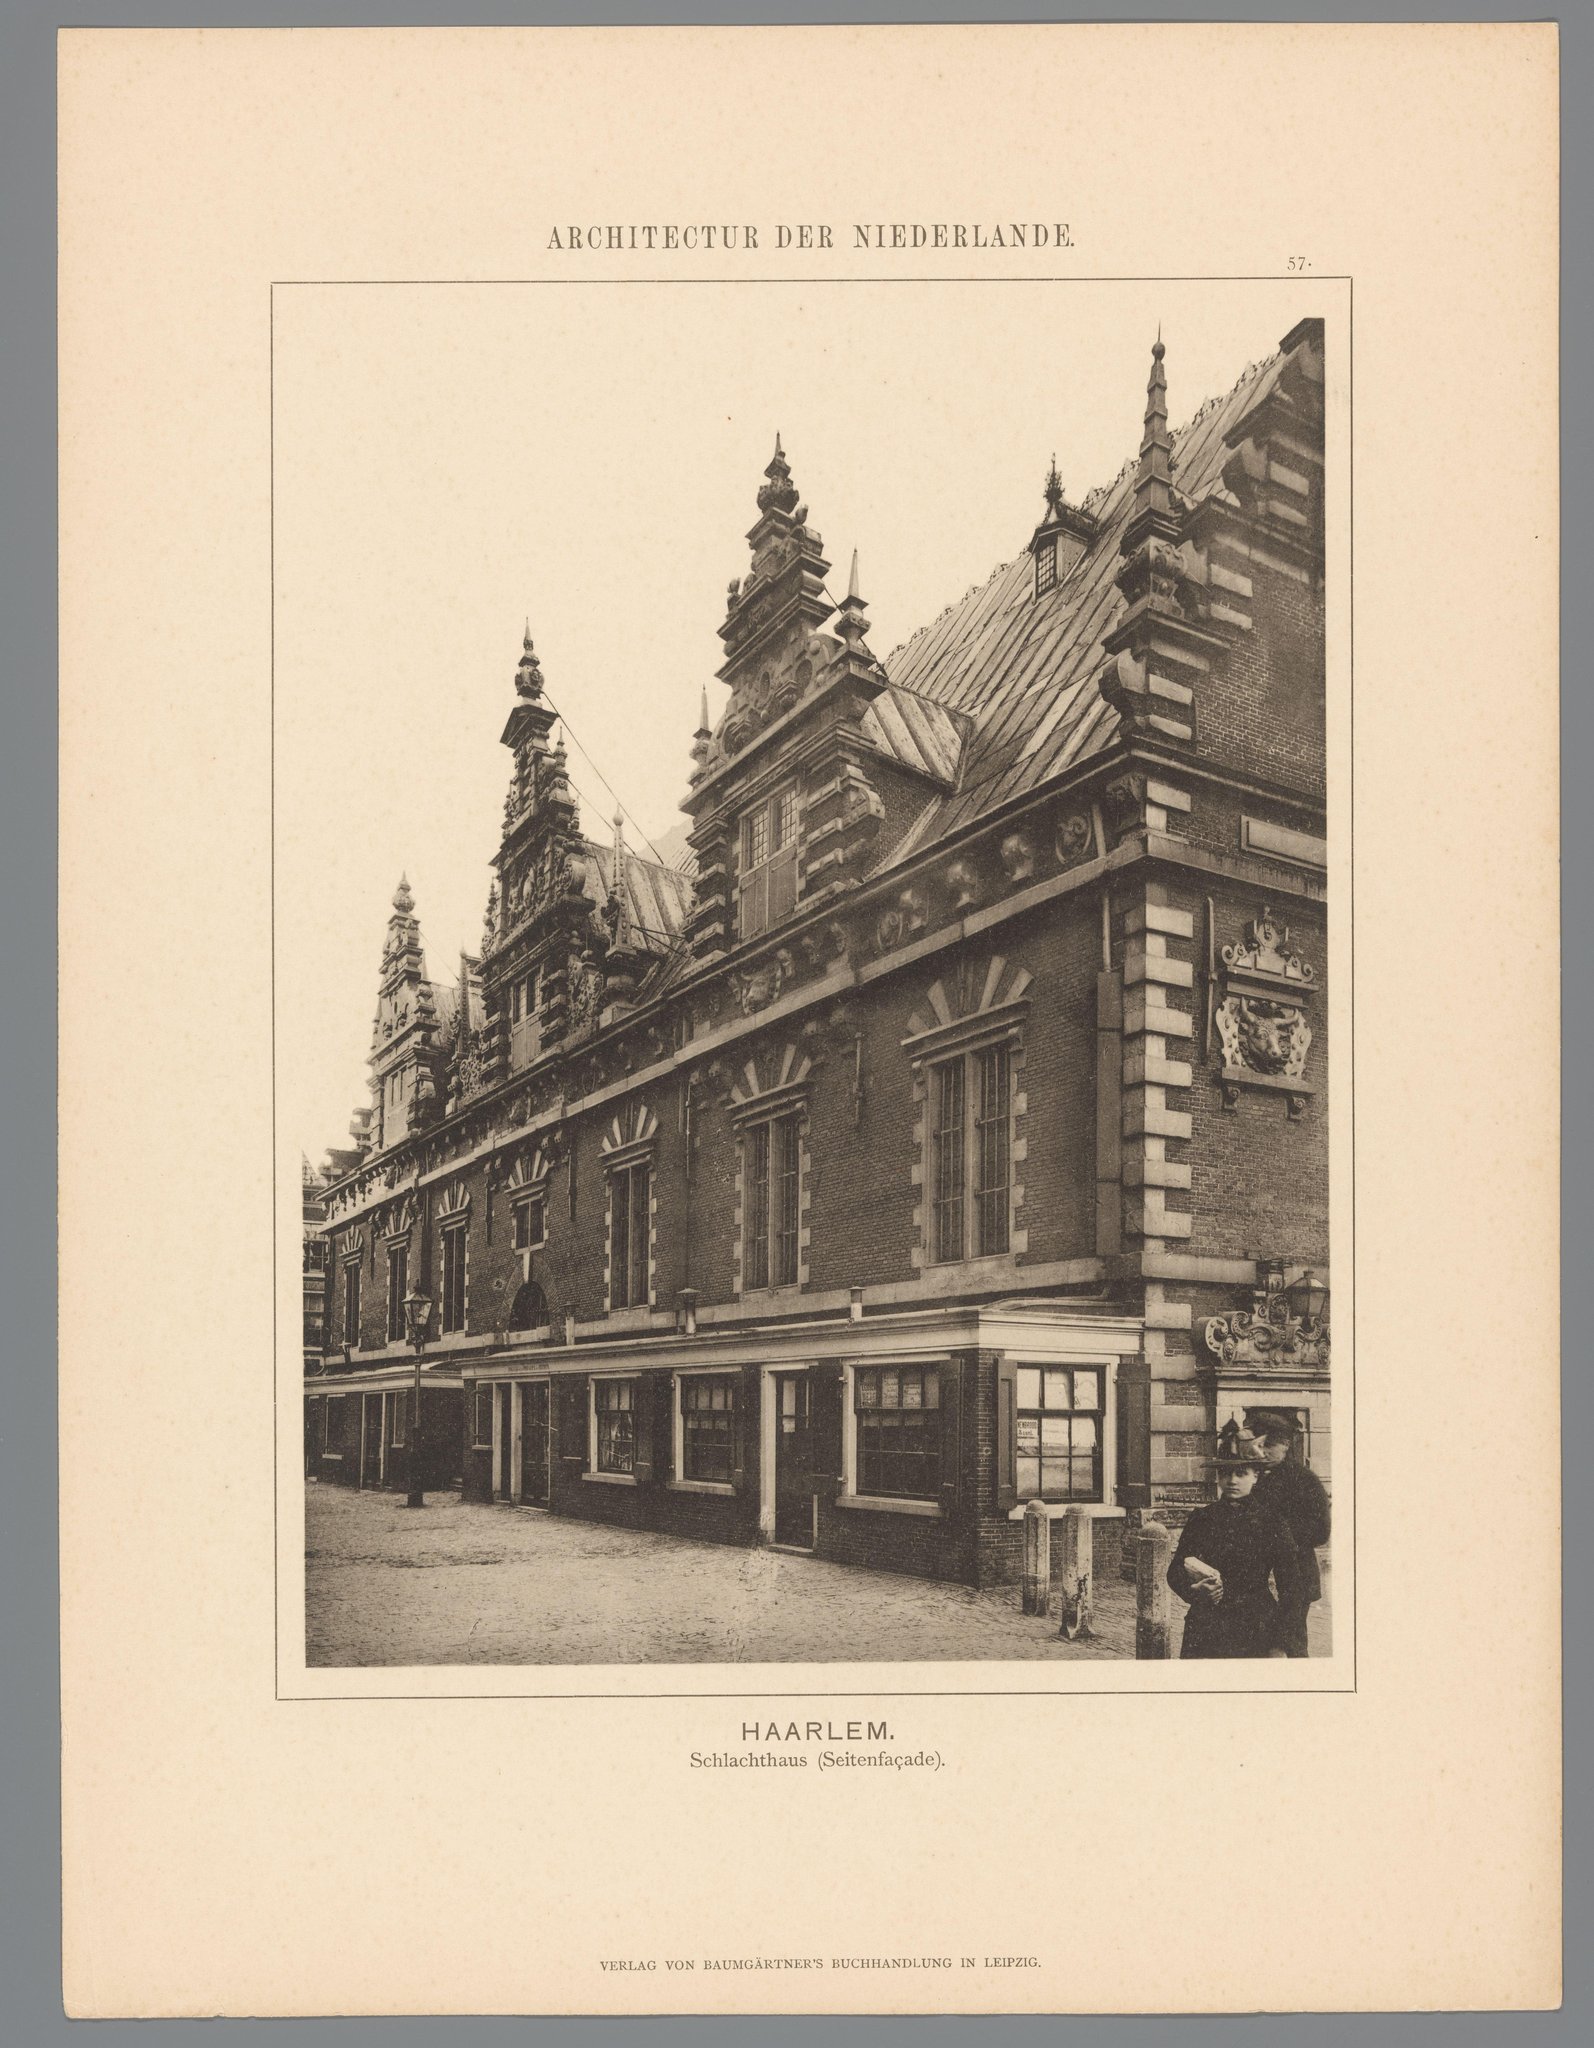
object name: photomechanical print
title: Haarlem. Schlachthaus (Seitenfaçade)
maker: Anonymous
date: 1894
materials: paper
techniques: photograph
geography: leipzig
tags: market-hall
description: Afdruk uit: Krook, L. Architectur der Niederlande. Leipzig: Baumgärtner's Buchhandlung, 1894.